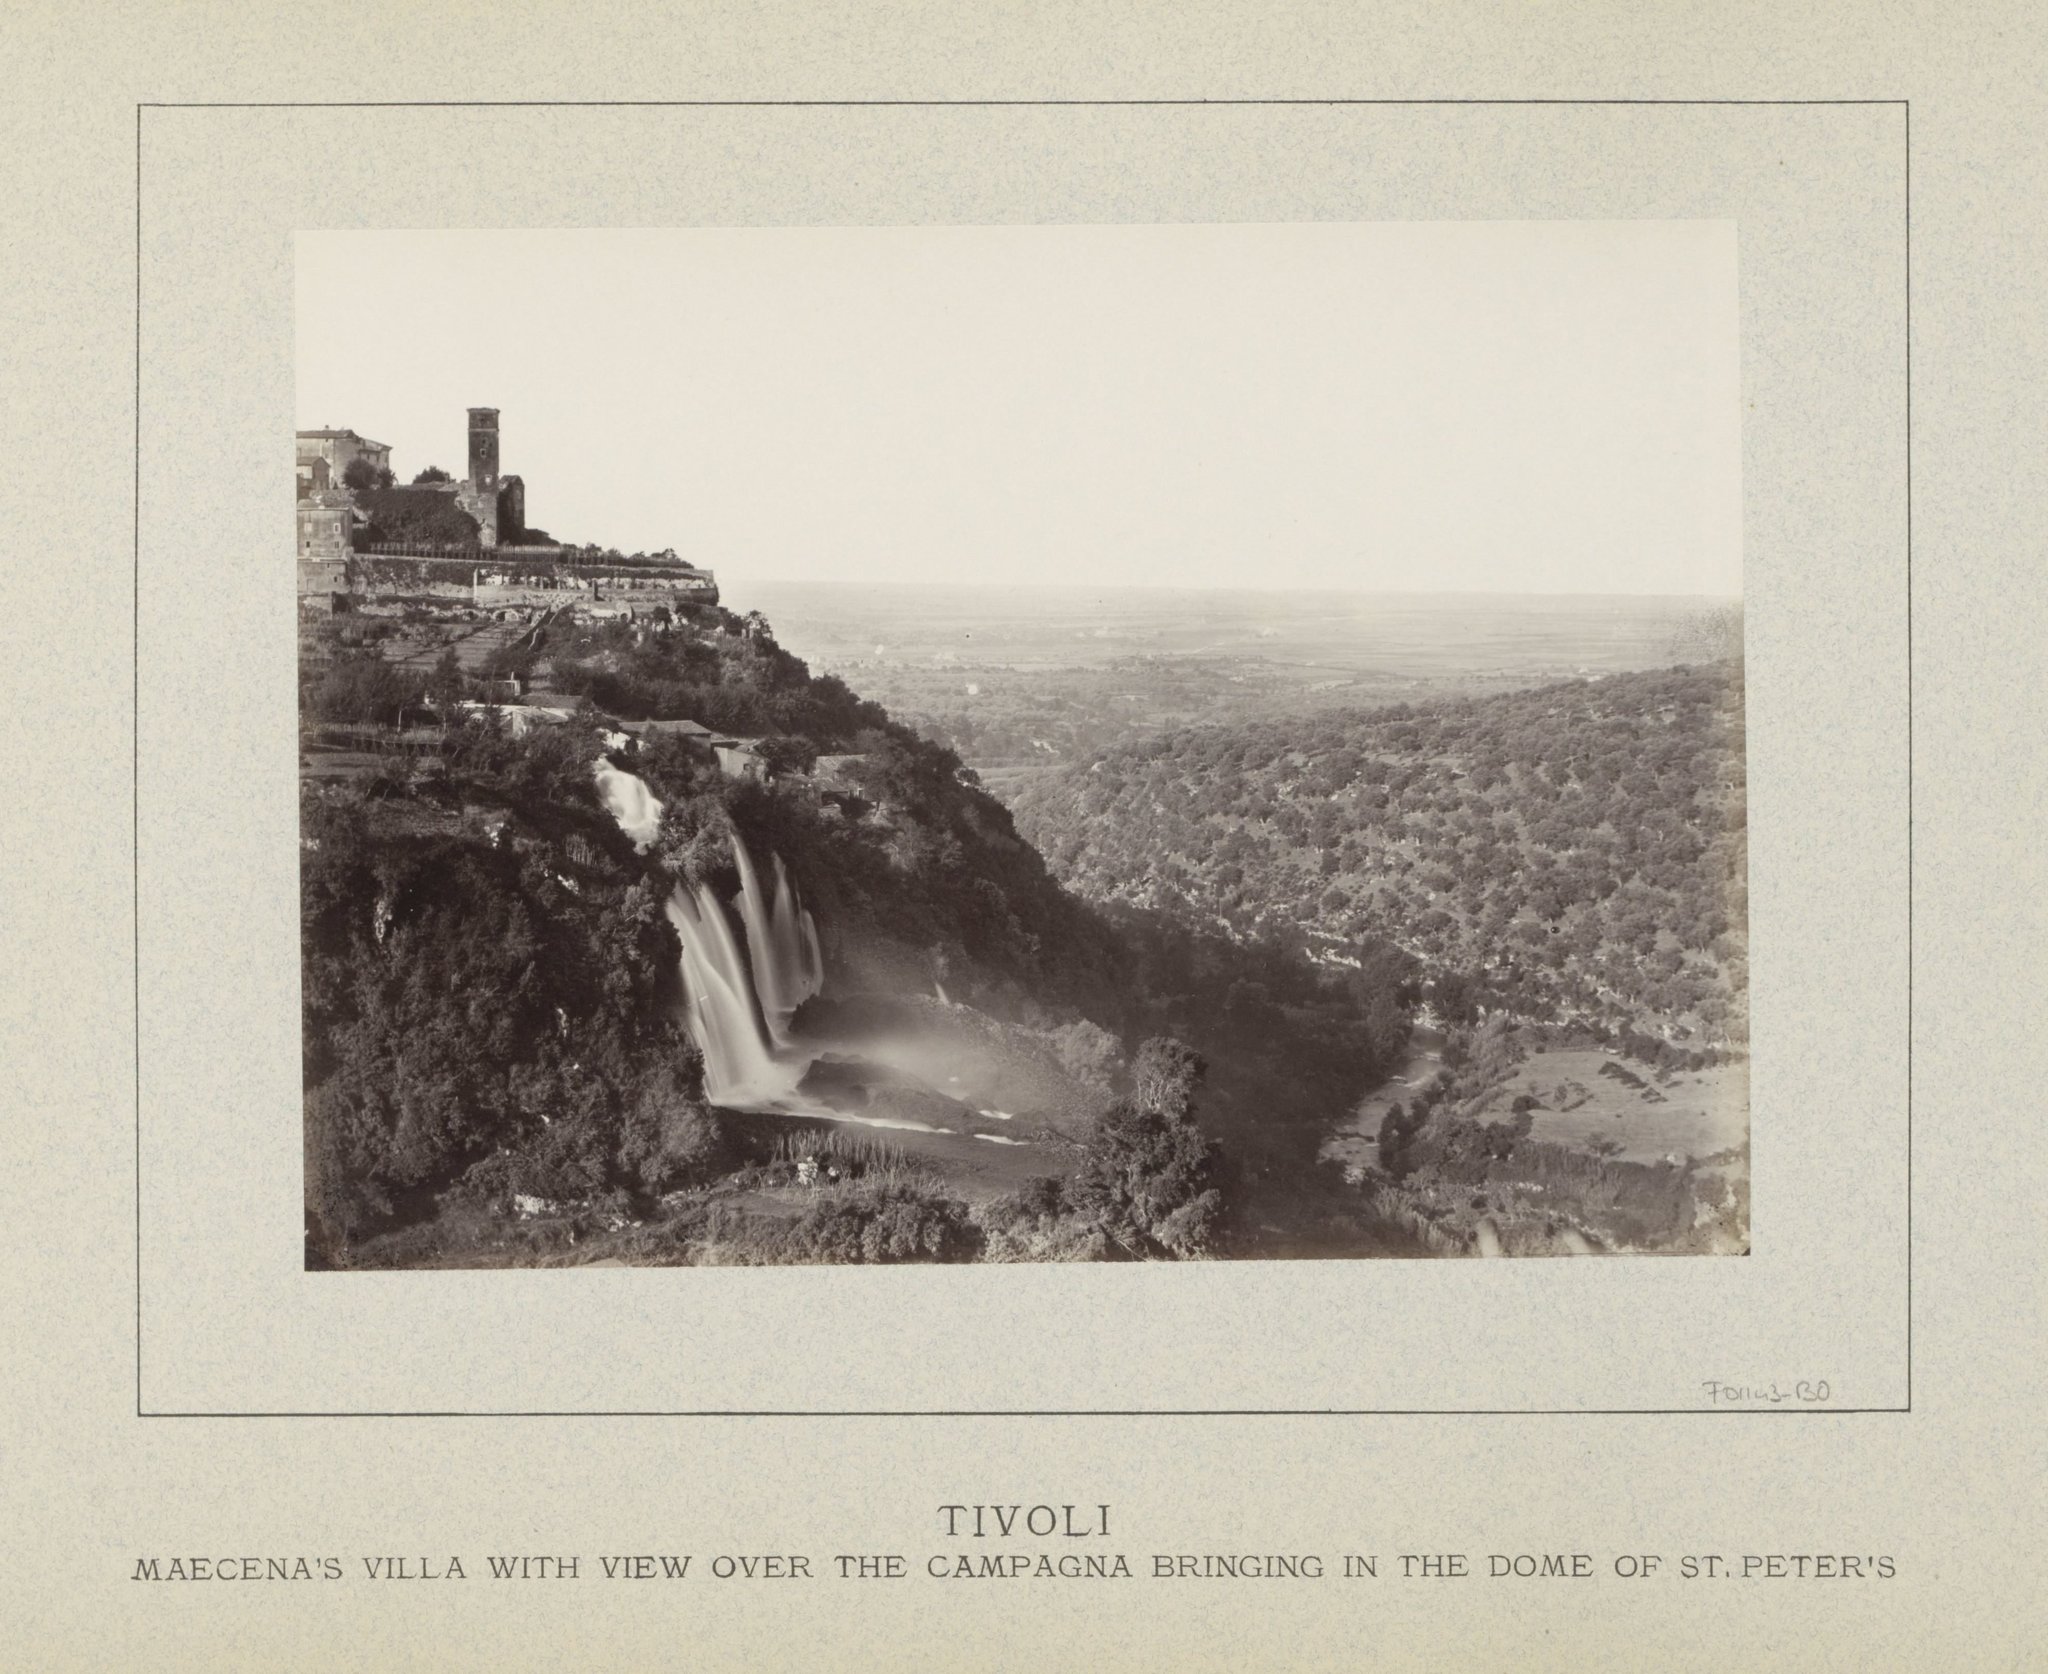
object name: photograph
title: Tivoli, maecena's villa with view over the Campagna bringing in the Dome of St. Peter's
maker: Anonymous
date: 1860-1900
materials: photographic support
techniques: albumen print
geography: tivoli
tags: villa, waterfall (+ landscape with figures, staffage), temple of hercules victor, tivoli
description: Onderdeel van Fotoalbum met opnames van bezienswaardigheden en kunstwerken in Rome.